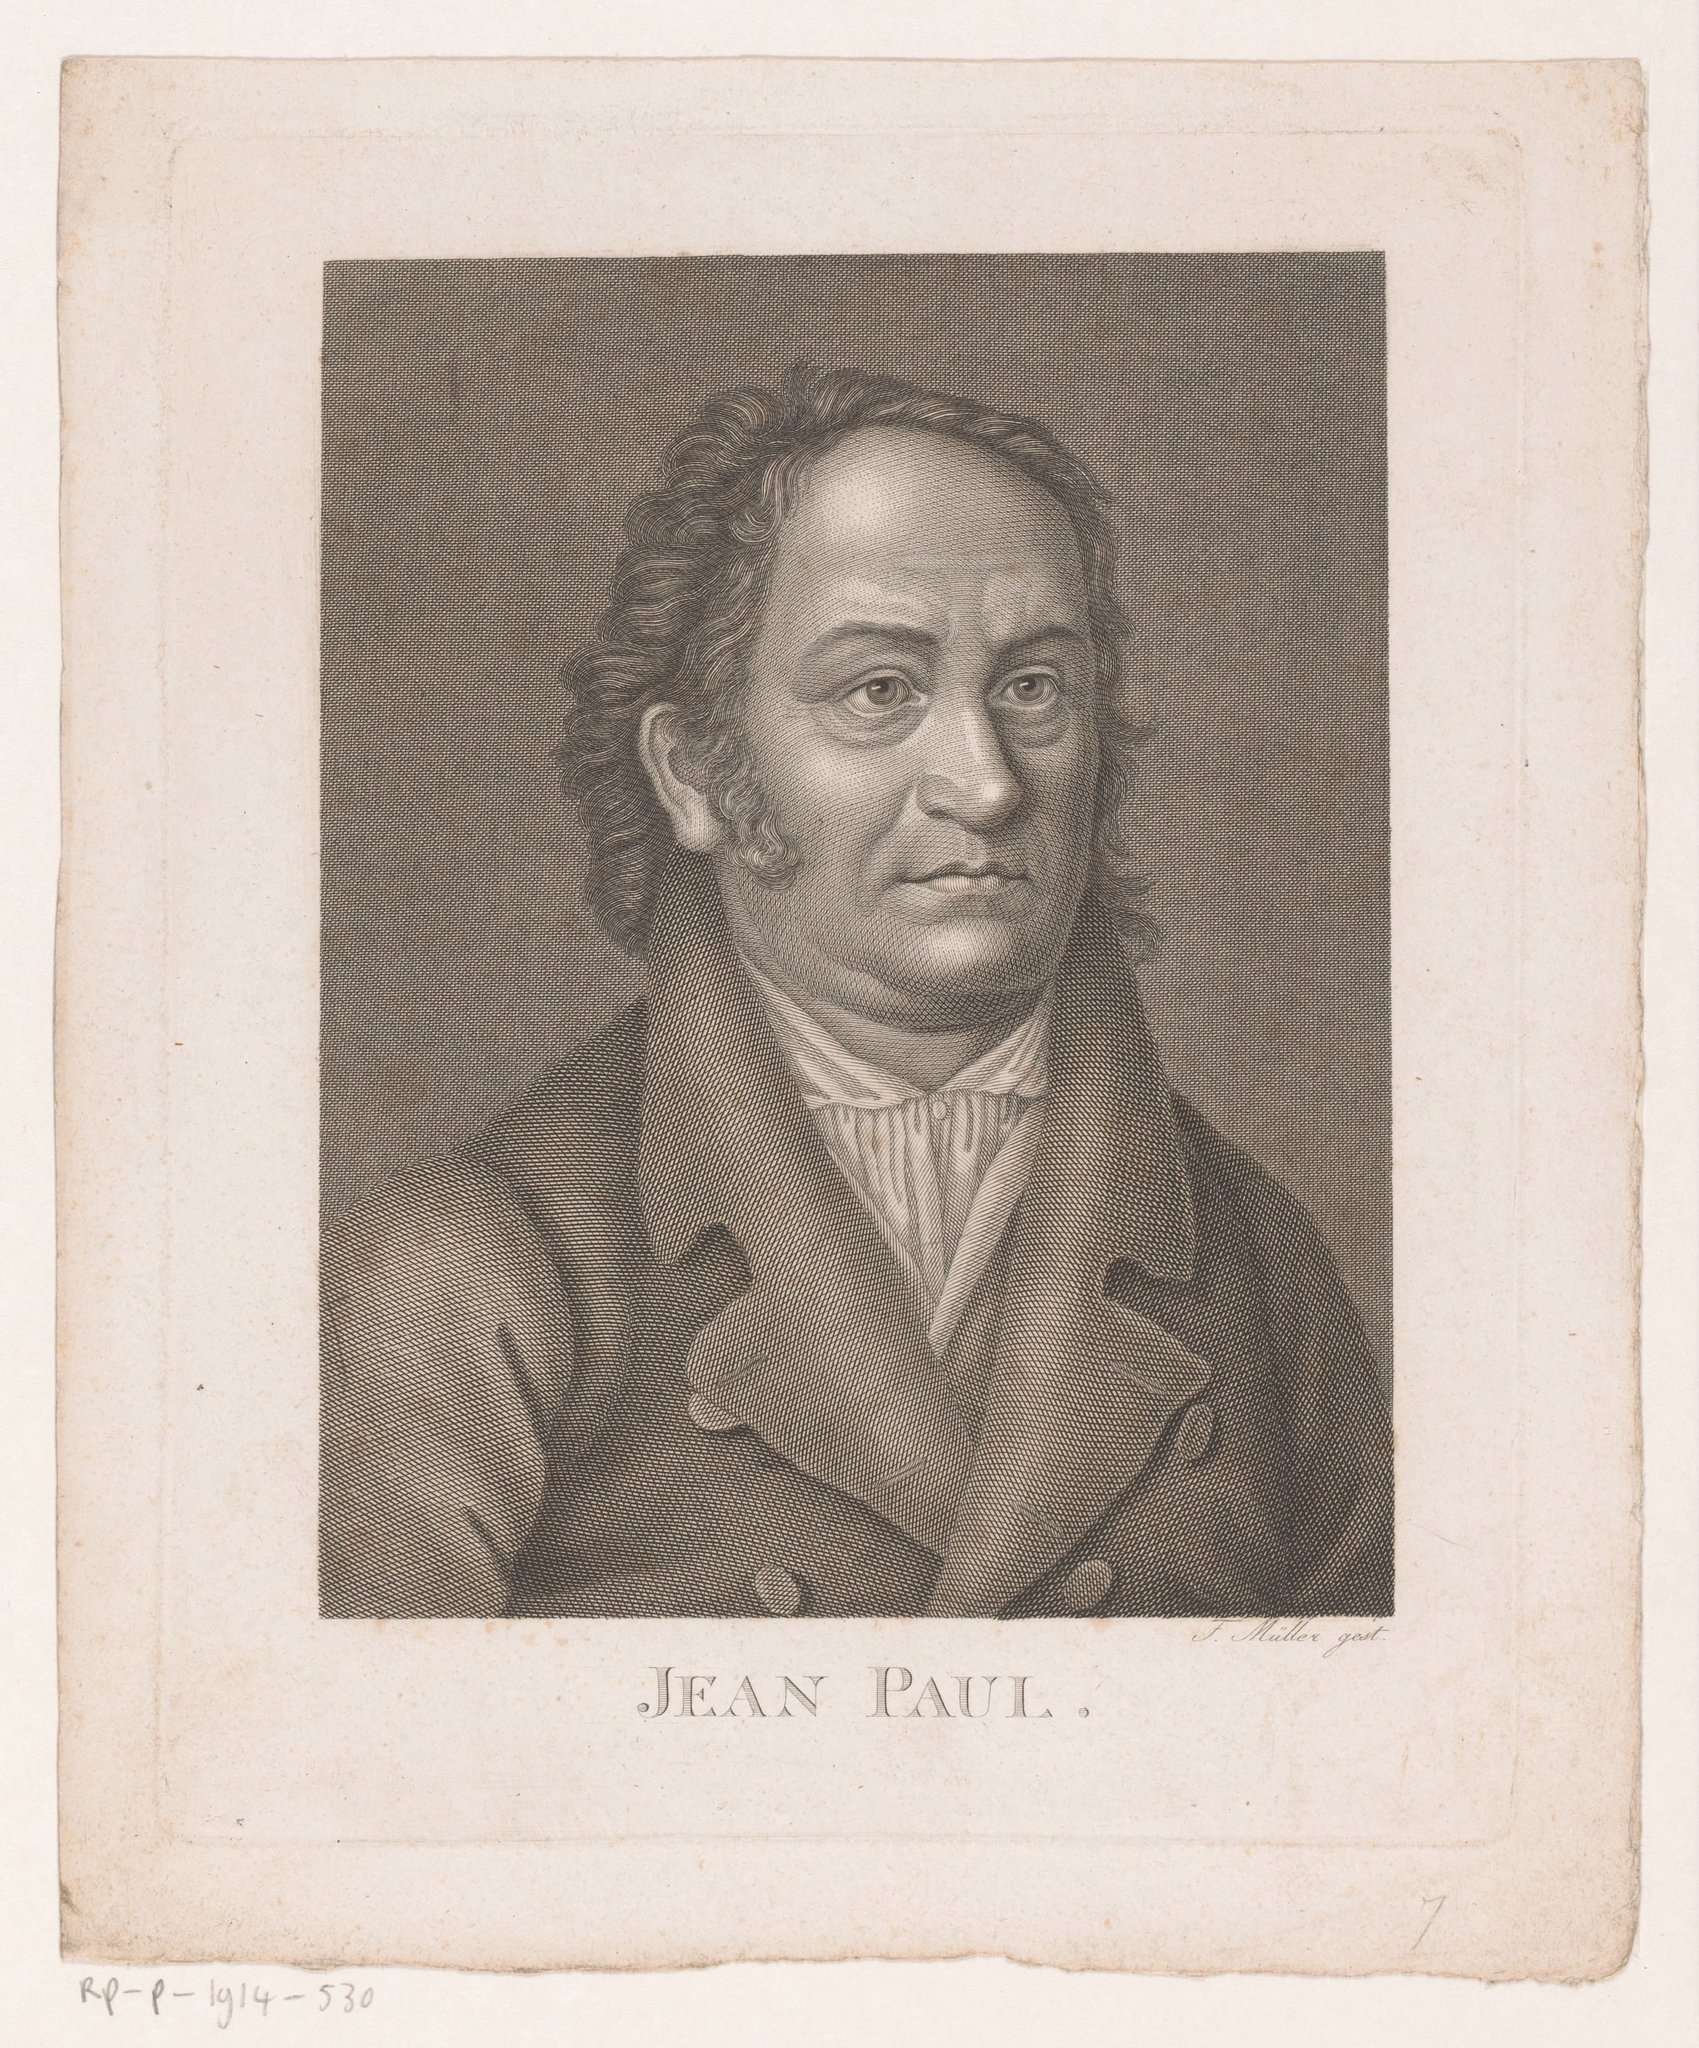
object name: print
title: Portret van Jean Paul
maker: johann friedrich wilhelm müller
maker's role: draughtsman, print maker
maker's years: 1782-1816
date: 1792-1816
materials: paper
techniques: engraving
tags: jean paul, historical persons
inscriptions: collector's mark: Lugt 2228